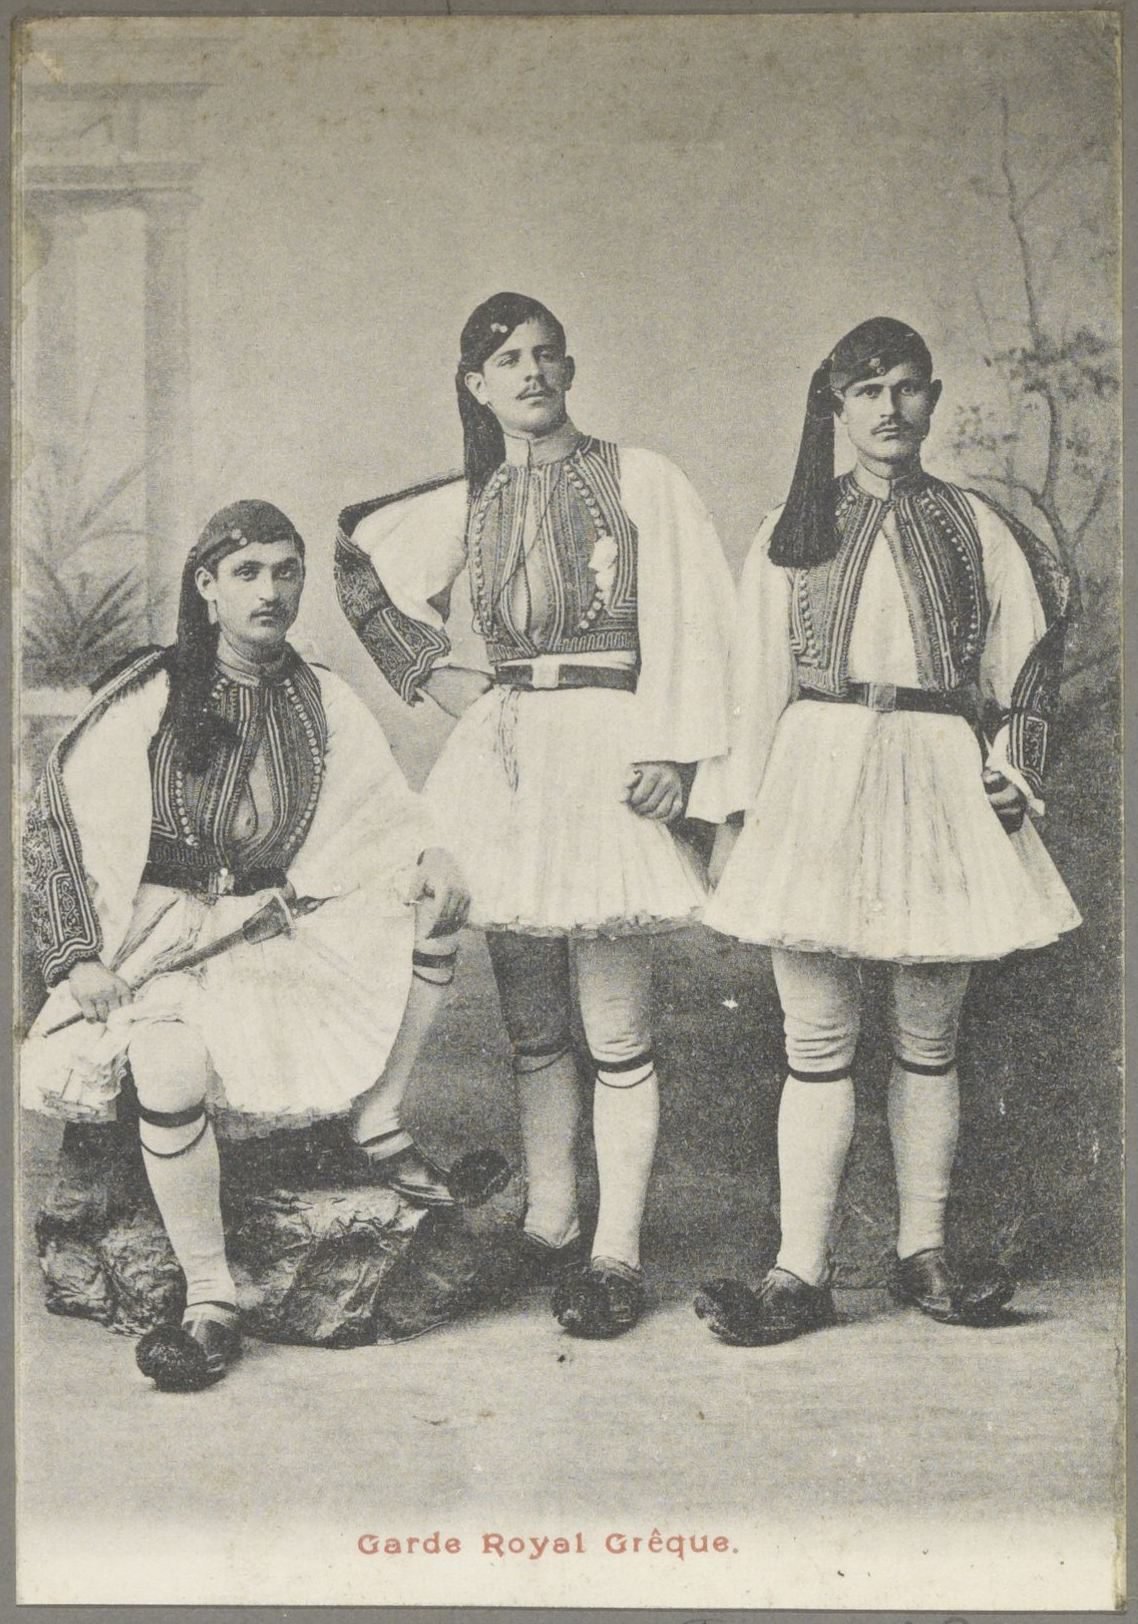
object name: ansichtkaart, prentbriefkaart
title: Garde Royal Grêque.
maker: Anonymous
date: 1895-1905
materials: paper, photographic support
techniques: photograph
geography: greece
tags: guardian, studio requisites ~ photographer, folk costume, regional costume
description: Onderdeel van Reisalbum met foto's van bezienswaardigheden in Griekenland en Egypte.